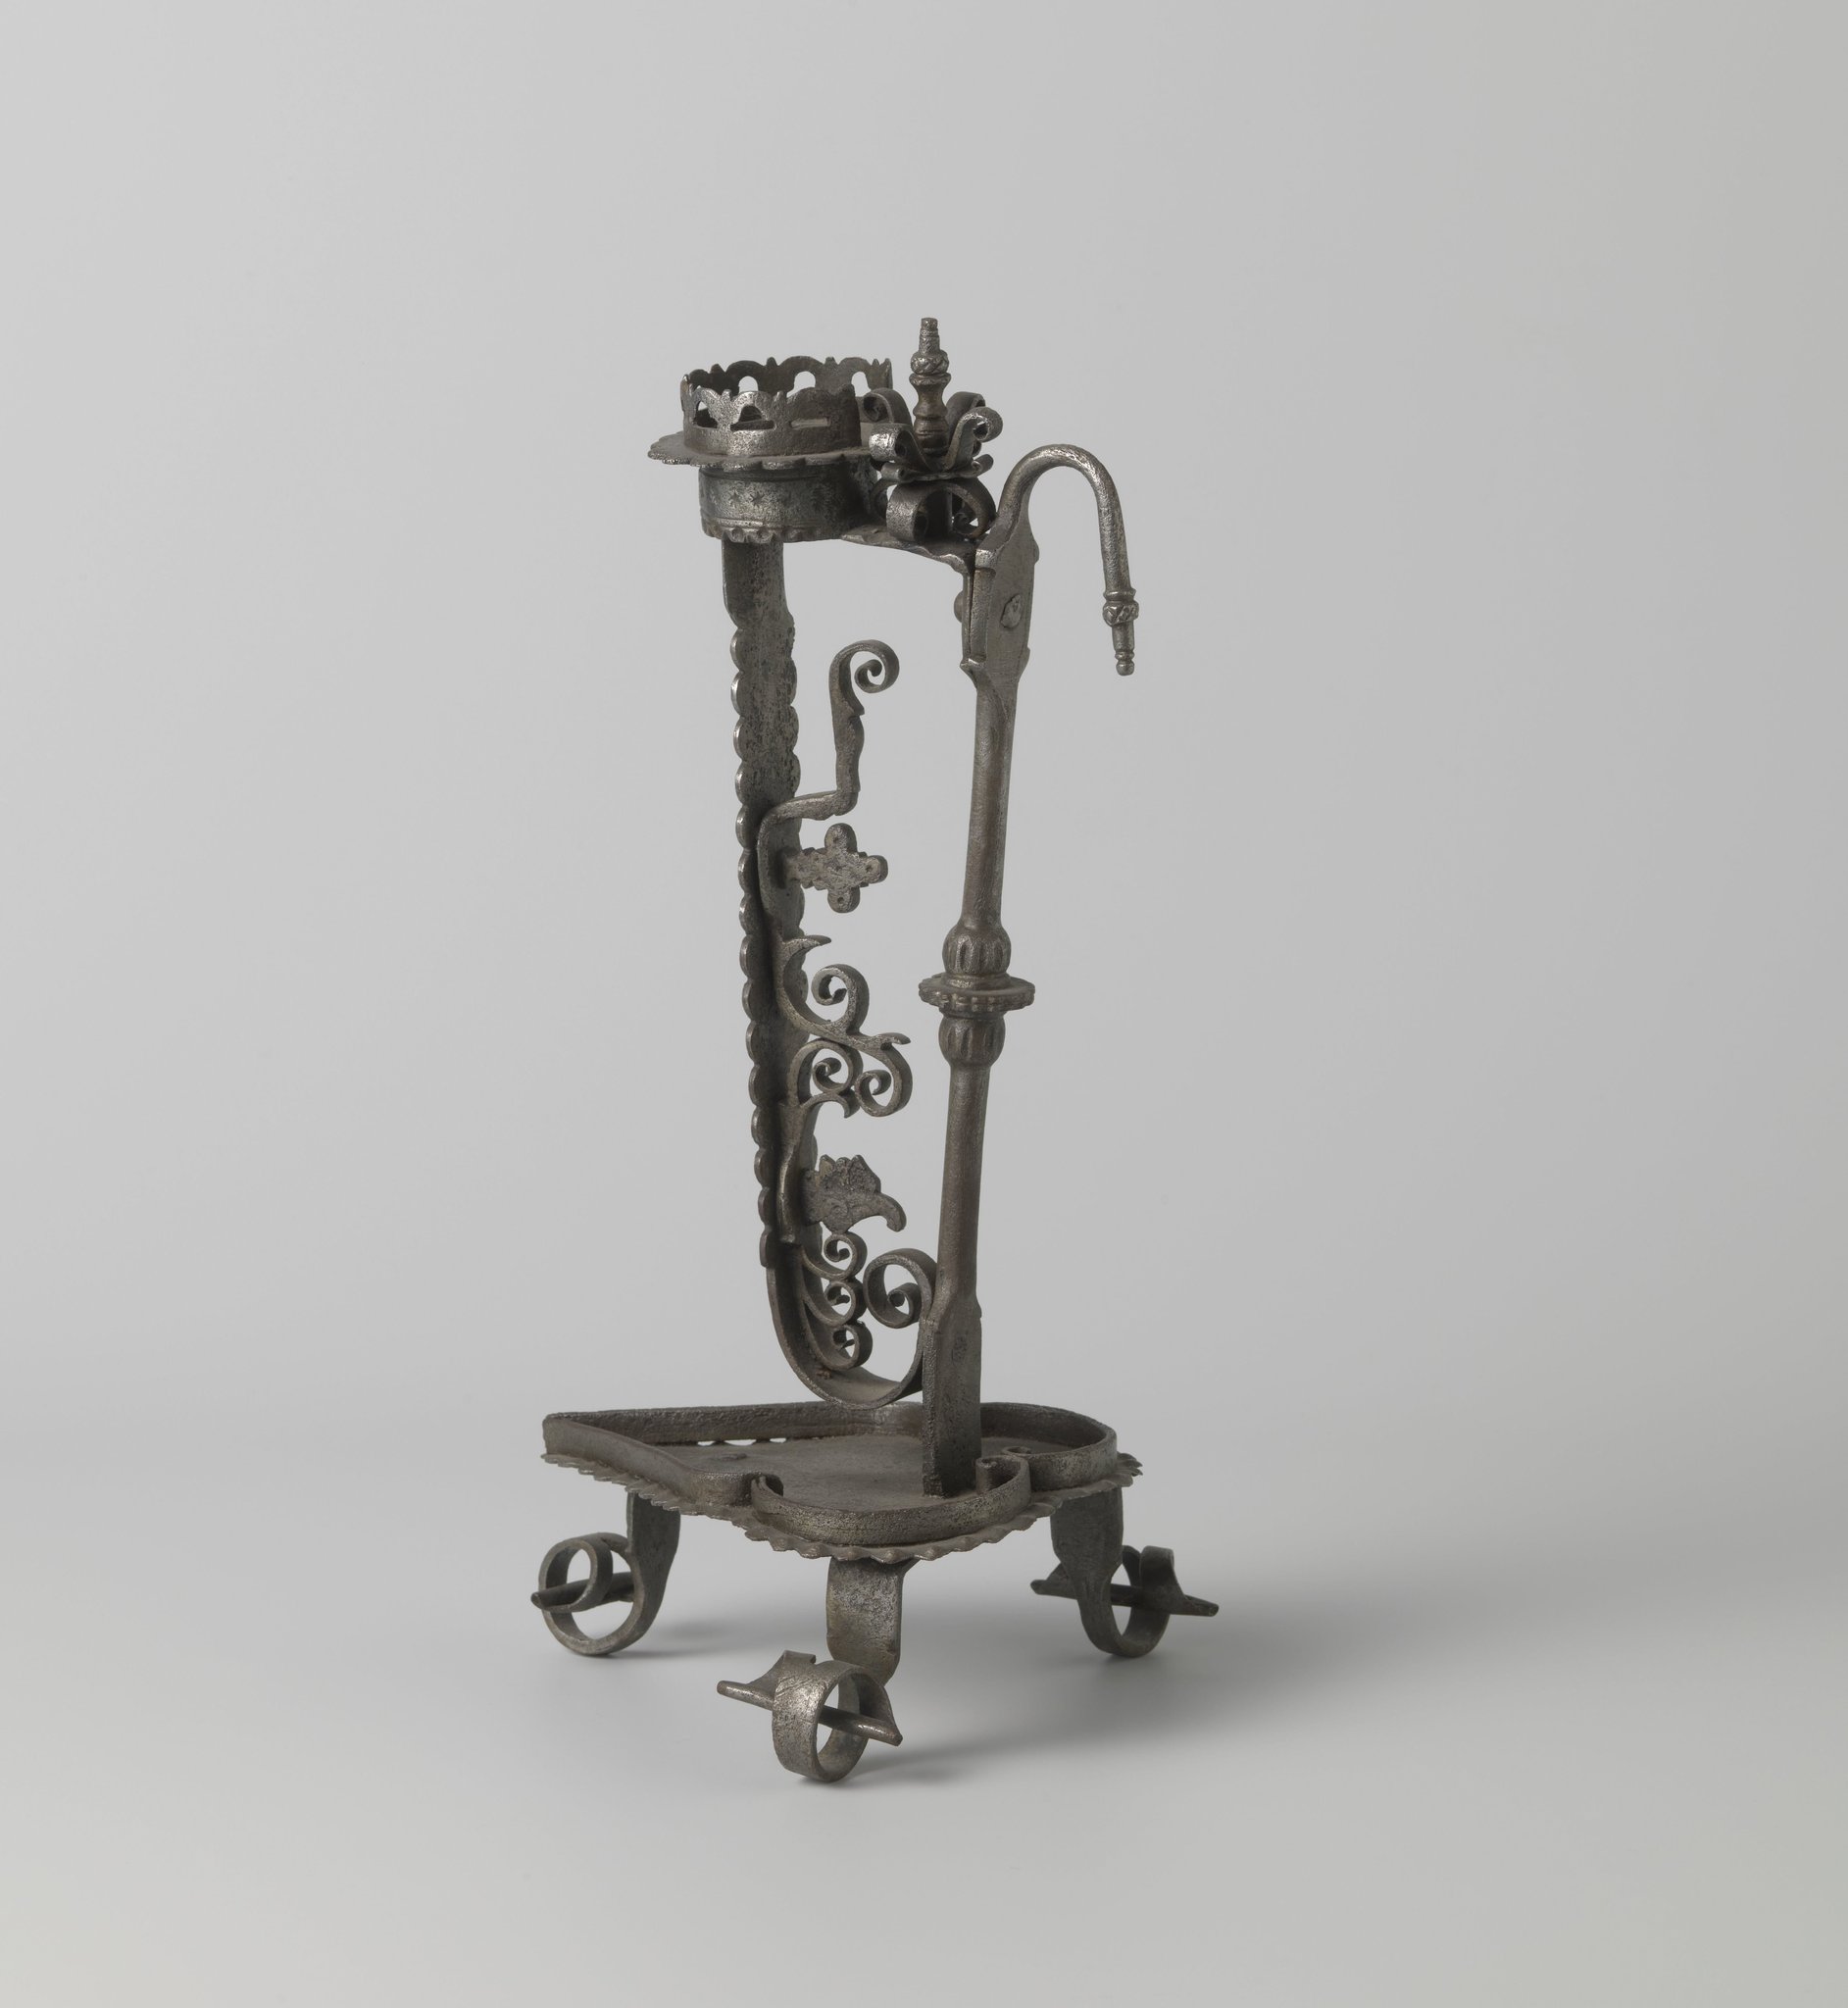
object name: candlestick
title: Kandelaar met veermechanisme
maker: Anonymous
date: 1500-1700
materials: iron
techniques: forging, riveted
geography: western europe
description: Kandelaar van smeedijzer op drie platte poten, die onderaan naar binnen omkrullen. Daarboven een bladvormige platte plaat met opstaande rand geklonken, die dienst doet als vetvanger. Naast de naar binnen wijzende punt van de bladvorm is de stam geklonken, die onder- en bovenaan plaat is, en tussen in rond met in het midden een platte, gekartelde schijf tussen twee gecanneleerde bolvormen. Boven aan krult de stam iets om, waardoor een klein handvat ontstaat. Aan de stam geklonken is de kaarsenhouder met een kroonachtig ornament. Onderaan de stam is de veer geklonken, eindigend in de kaarsenhouder en versierd met enkele opgewerkte krullen en andere ornamenten tussen de veer en de stam. D.m.v. de veer is de hoogte van kaars verstelbaar.